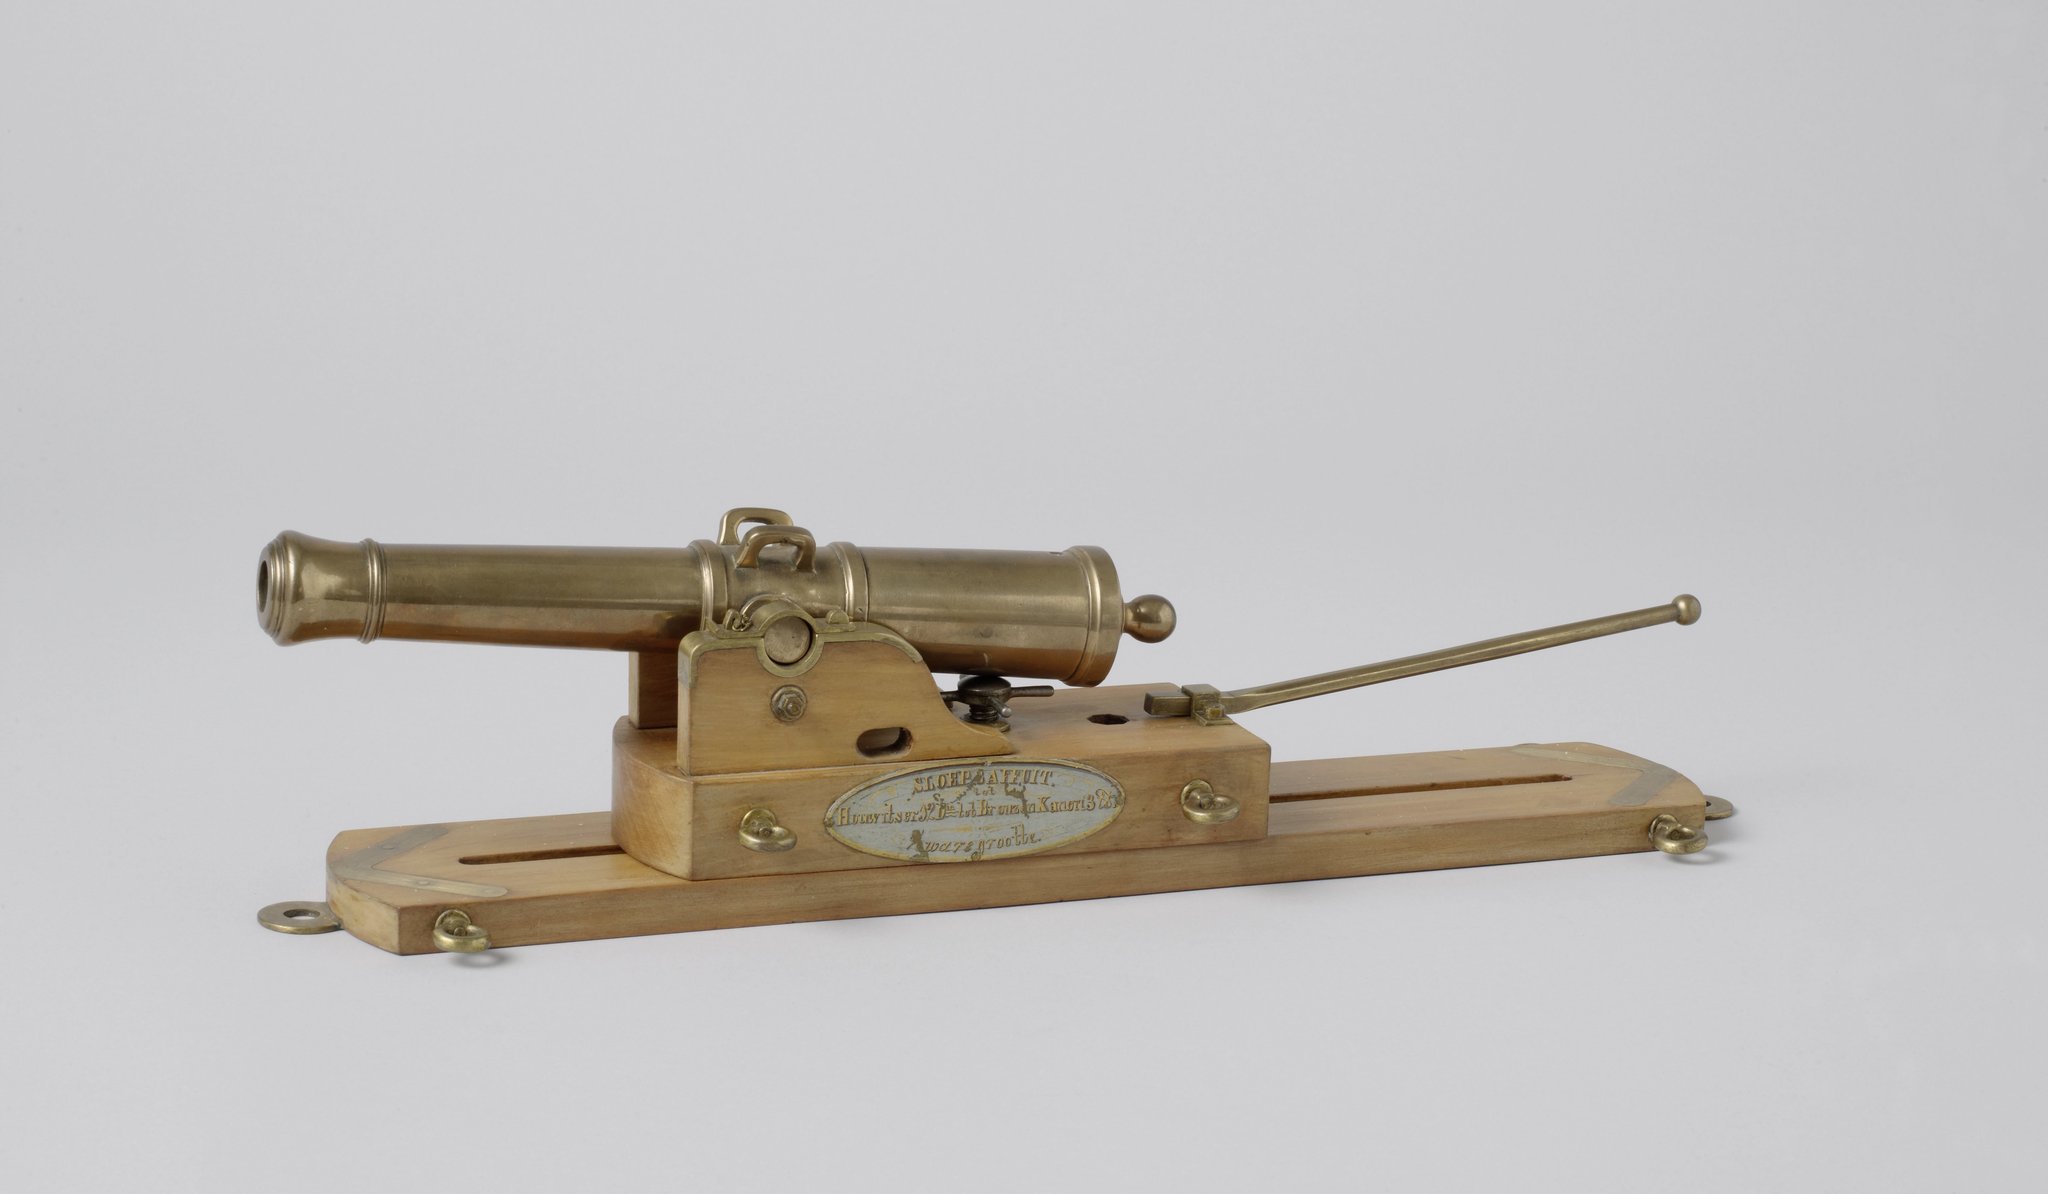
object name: demonstration model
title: Model of a 3-Pounder Gun on a Slide for a Launch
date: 1855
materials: bronze, copper, wood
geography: amsterdam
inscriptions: inscription, on the slide: ‘SLOEPSAFFUIT. / tot / Houwitser 12 Dm tot Bronzen Kanon 3-pounder / 1/5 ware grootte.’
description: Model van een kanon op een schuifslede voor sloepen. De tromp is tulpvormig en afgewerkt met een sierraadring. De 28 cm lange loop heeft een kaliber van 14 mm en twee sierraadbanden; op het tappenstuk zijn twee eenvoudige dolfijnen gegoten. Op het kulas zit een druif. Het affuit is een dikke rechthoekige plank, aan de voorkant afgerond, en waarop twee wangen verbonden door een messing stang. De wangen hebben ellipsvormige gaten onderaan voor de broeking en de tappannen zijn met messing bekleed. Het affuit heeft een wervelbout die in de geul van de slede vaart, een eleveerschroef die op twee posities gezet kan worden, een voor houwitser en een voor een kanon, en een baksijzer. De slede is een lang frame met een geul in het midden en is aan beide uiteinden afgerond met een oog voor een spilbout. Aan de hoeken van de slede en het affuit zijn oogbouten gemonteerd. Schaal 1:5 (schaal op model).